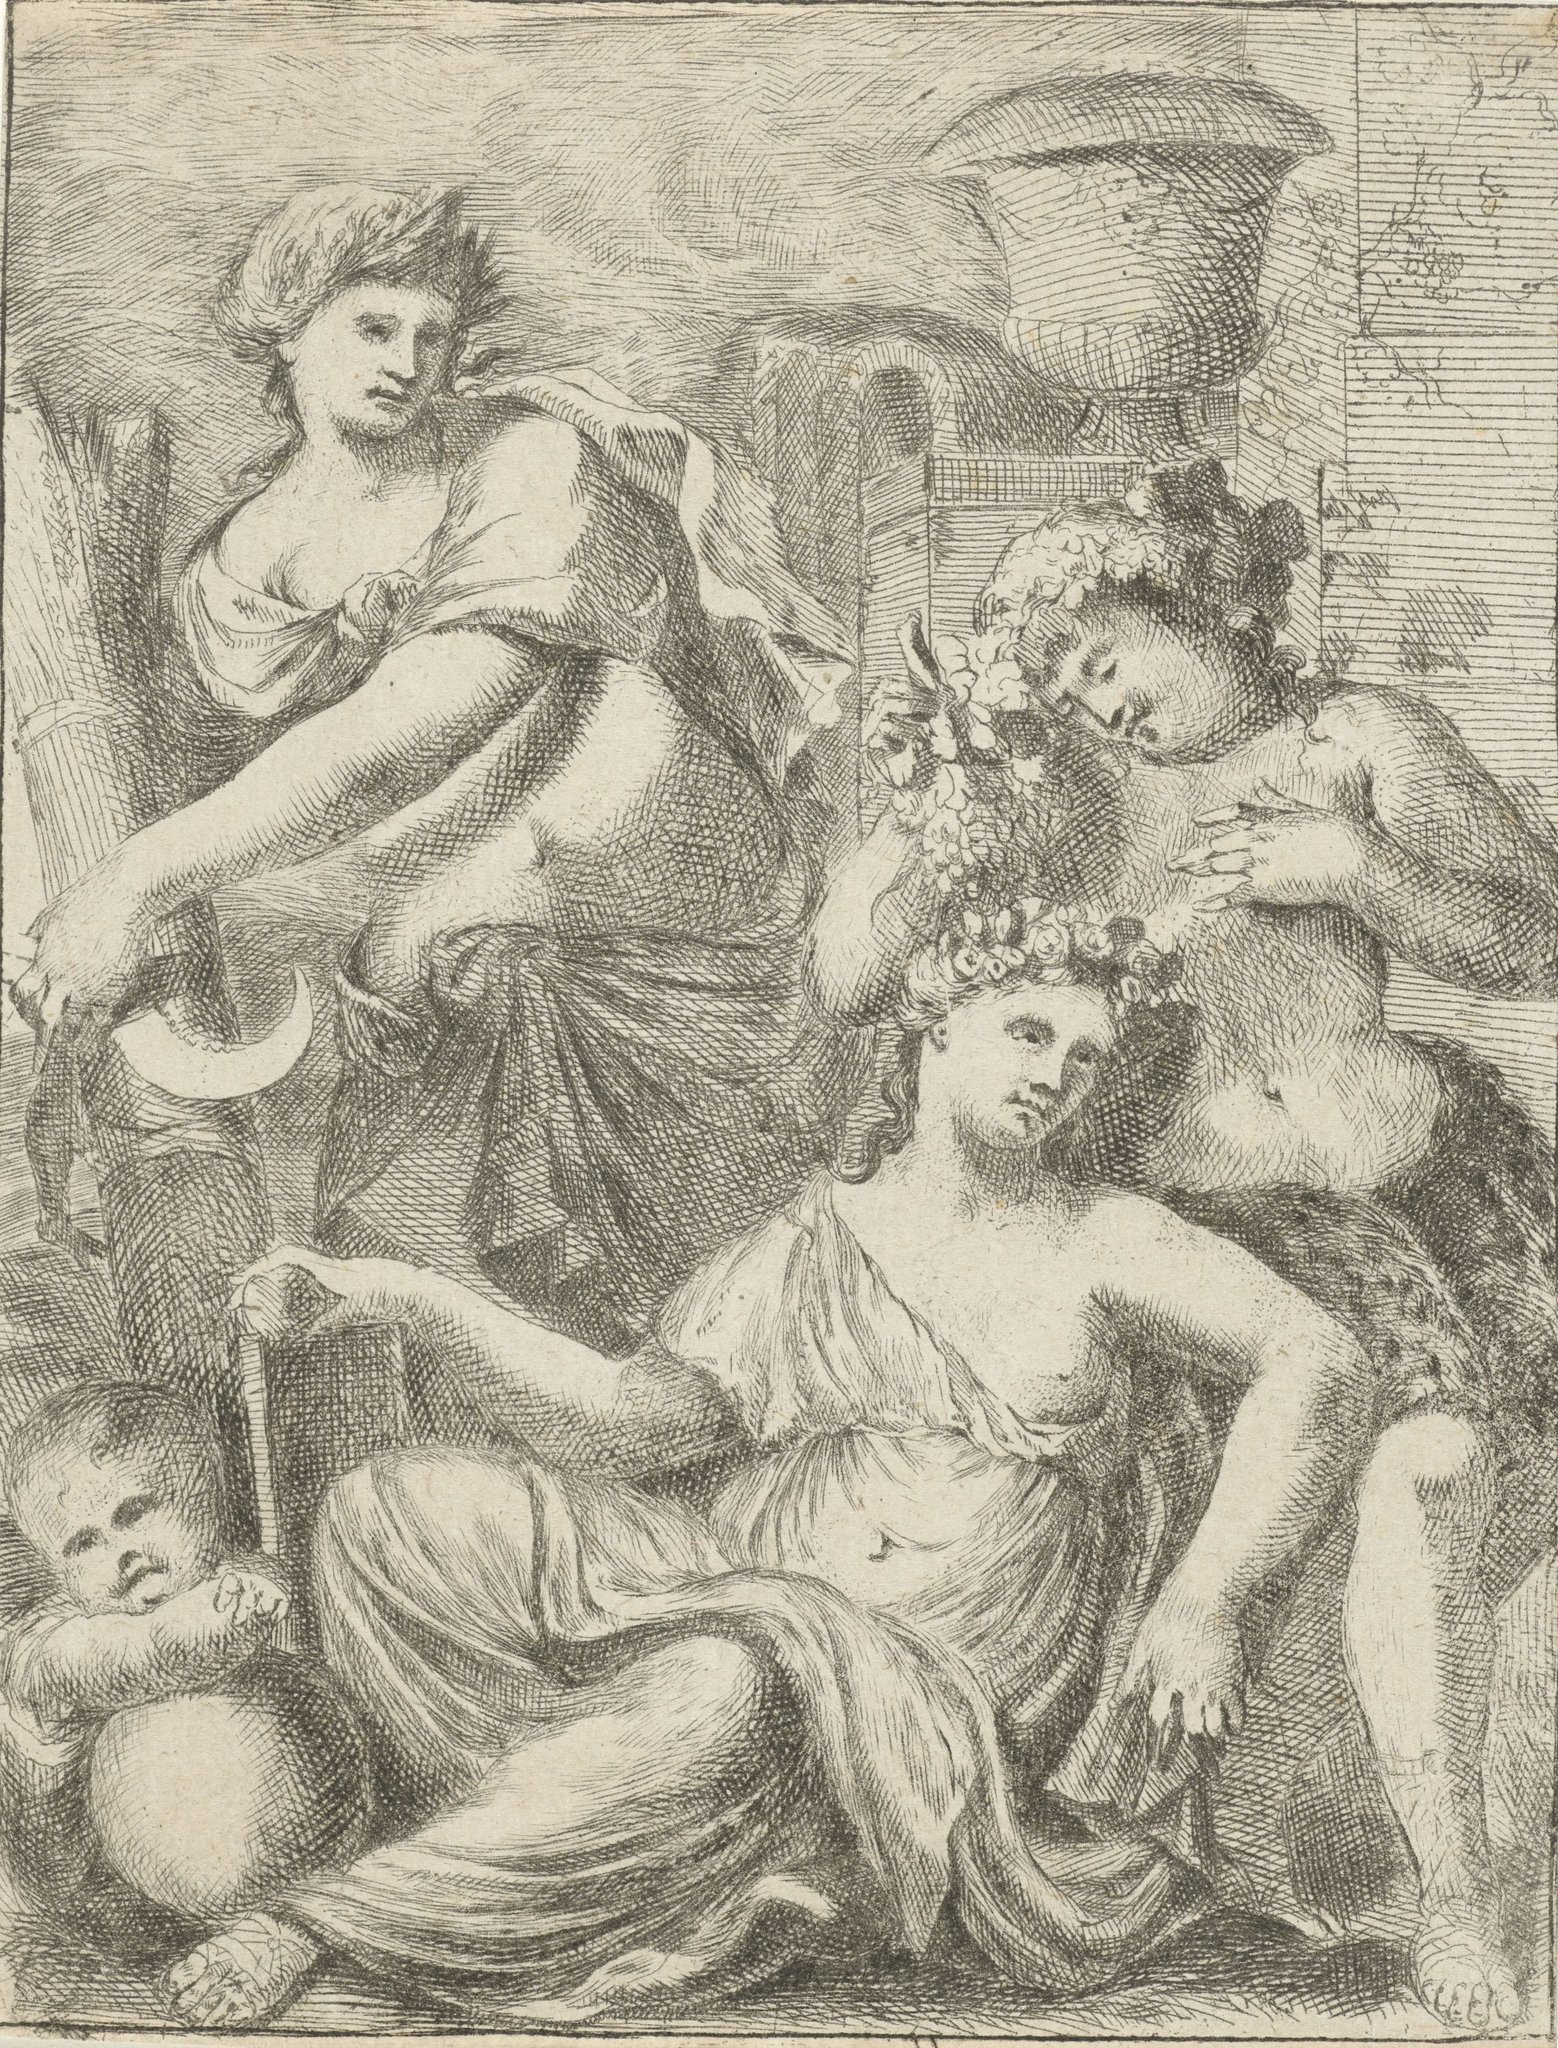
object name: print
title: Ceres, Bacchus en Venus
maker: pieter van der plas (ii)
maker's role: print maker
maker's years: 1647-1708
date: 1687-1708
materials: paper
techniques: engraving, etching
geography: northern netherlands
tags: 'sine cerere et baccho friget venus'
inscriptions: collector's mark: Lugt 2228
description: Venus en Amor, vergezeld door Ceres en Bacchus. Verbeelding van het gezegde 'Sine Cerere et Baccho friget Venus' (zonder brood en wijn bevriest de liefde).